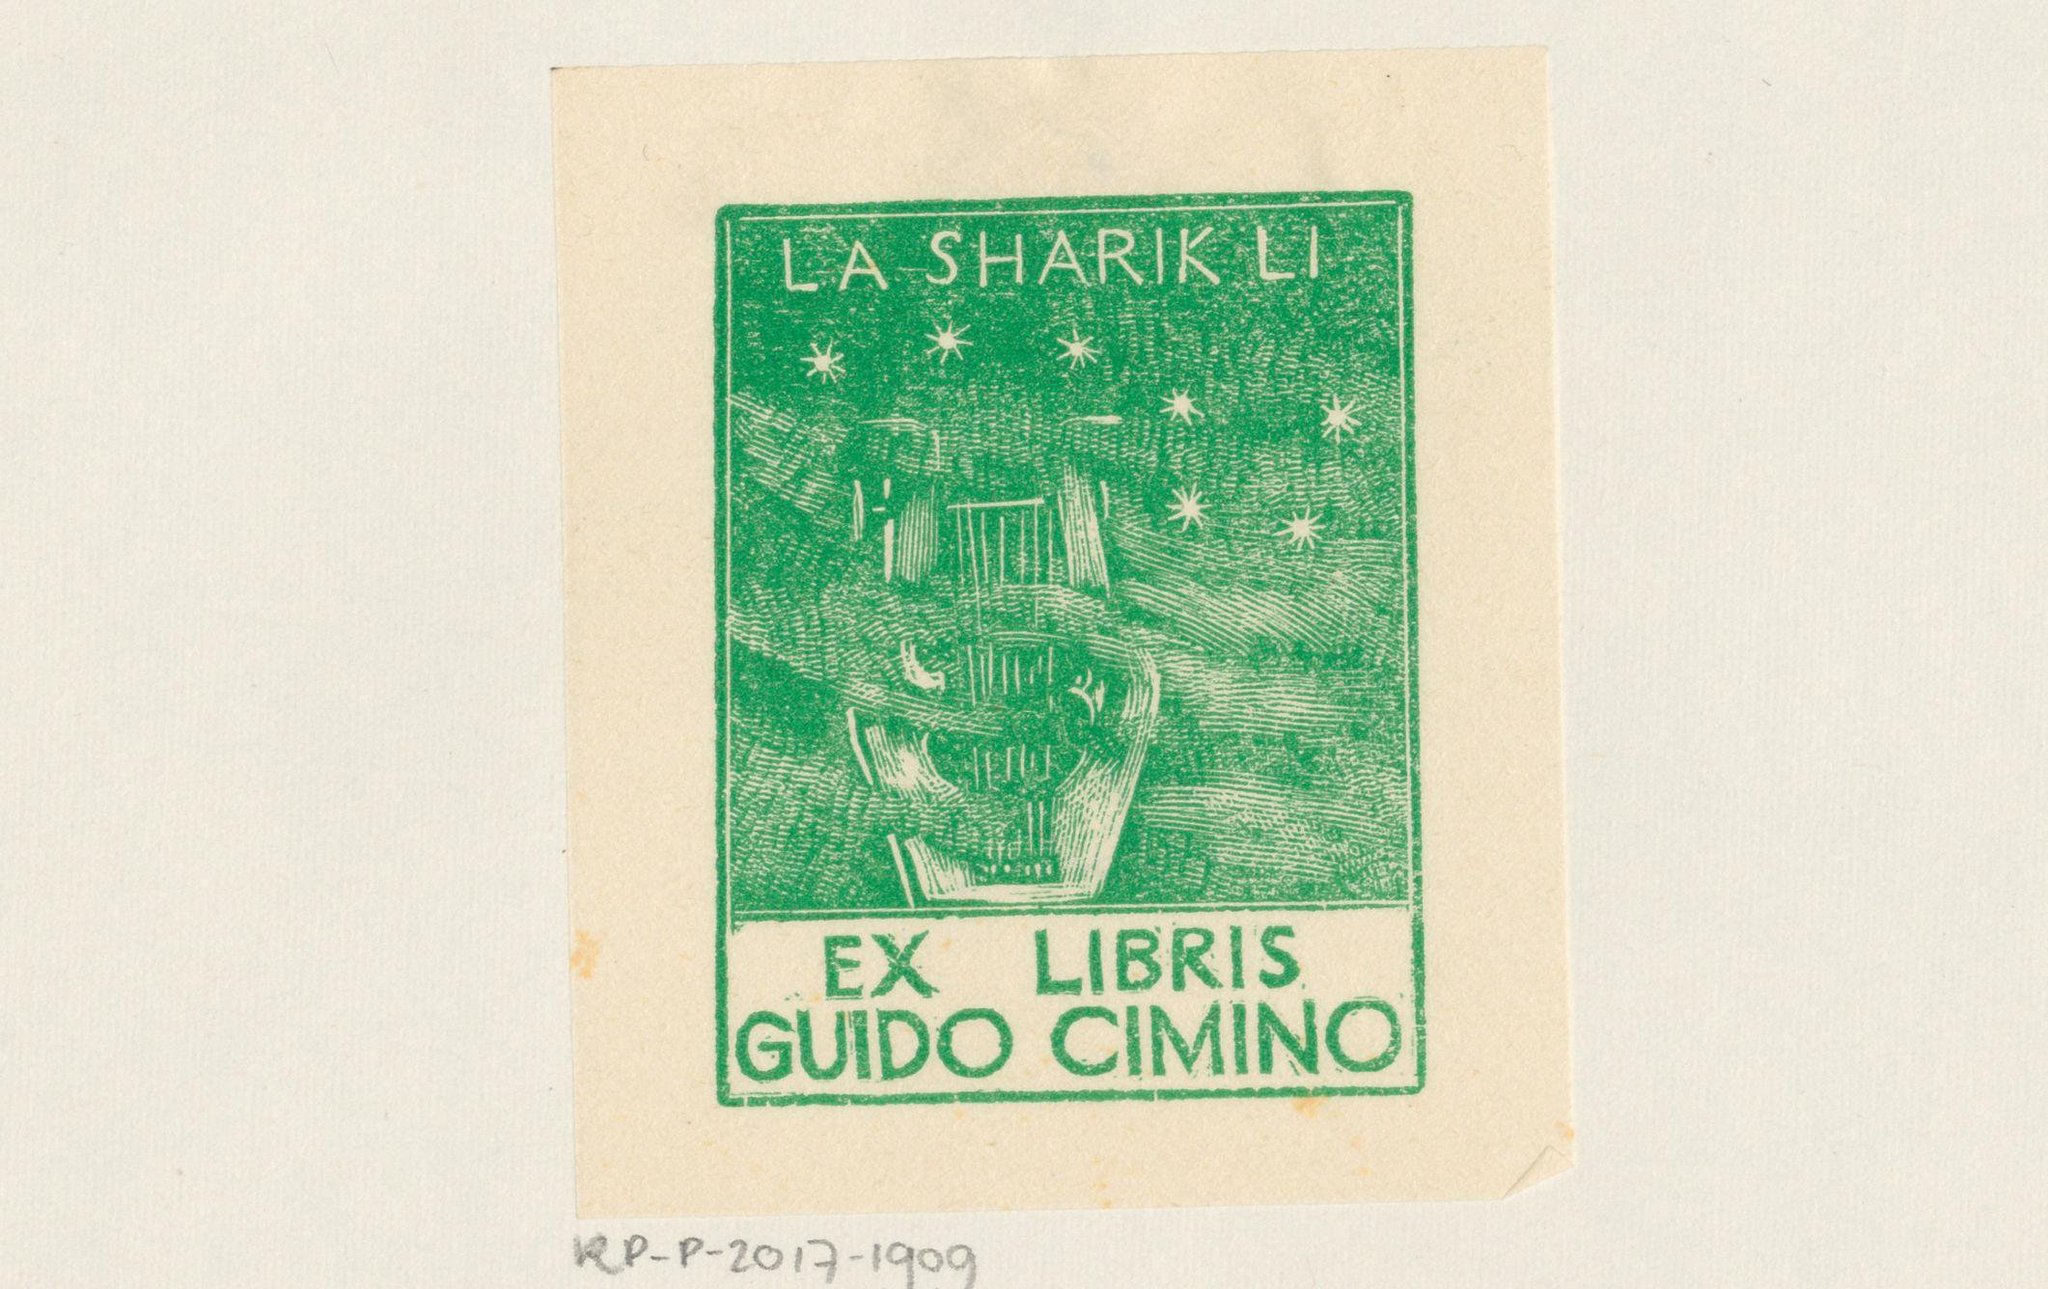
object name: bookplate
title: La sharik li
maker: Anonymous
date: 1900-1999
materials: paper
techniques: engraving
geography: italy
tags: lyre, cithara, psaltery, stars